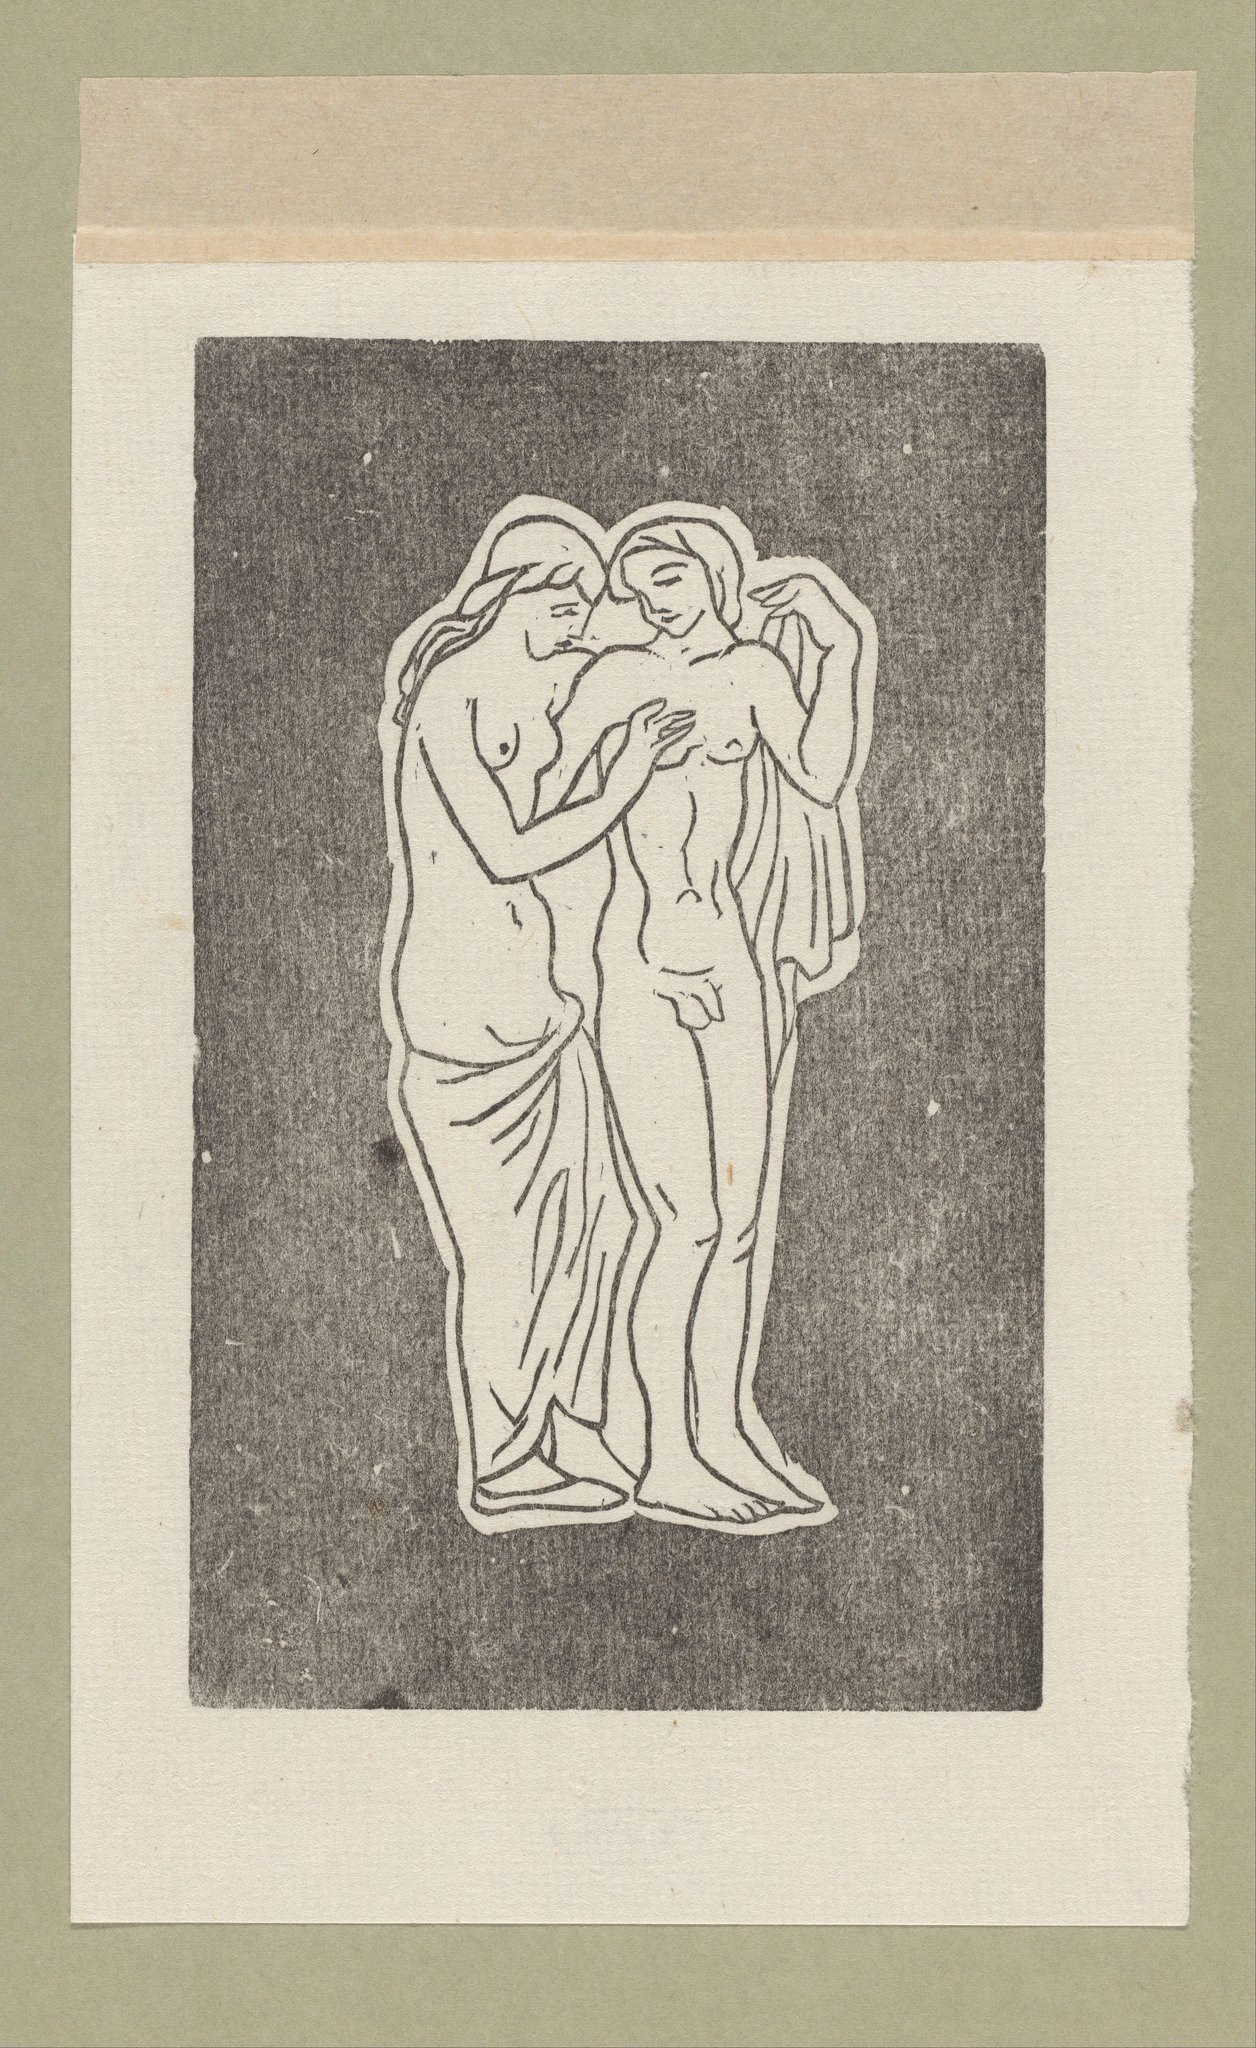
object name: book illustration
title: Groupe de Daphnis et Chloé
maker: aristide maillol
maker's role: draughtsman, painter, print maker, sculptor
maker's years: 1861-1944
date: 1937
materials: paper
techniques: woodcut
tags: daphnis (in greek mythology a shepherd who invented pastoral poetry, chloe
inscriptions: collector's mark: Lugt 2228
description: Latere staat van deze prent gebruikt in: Longus. Les Pastorales de Longus ou Daphnis & Chloé. Parijs: Frères Gonin, 1935, p. 194.